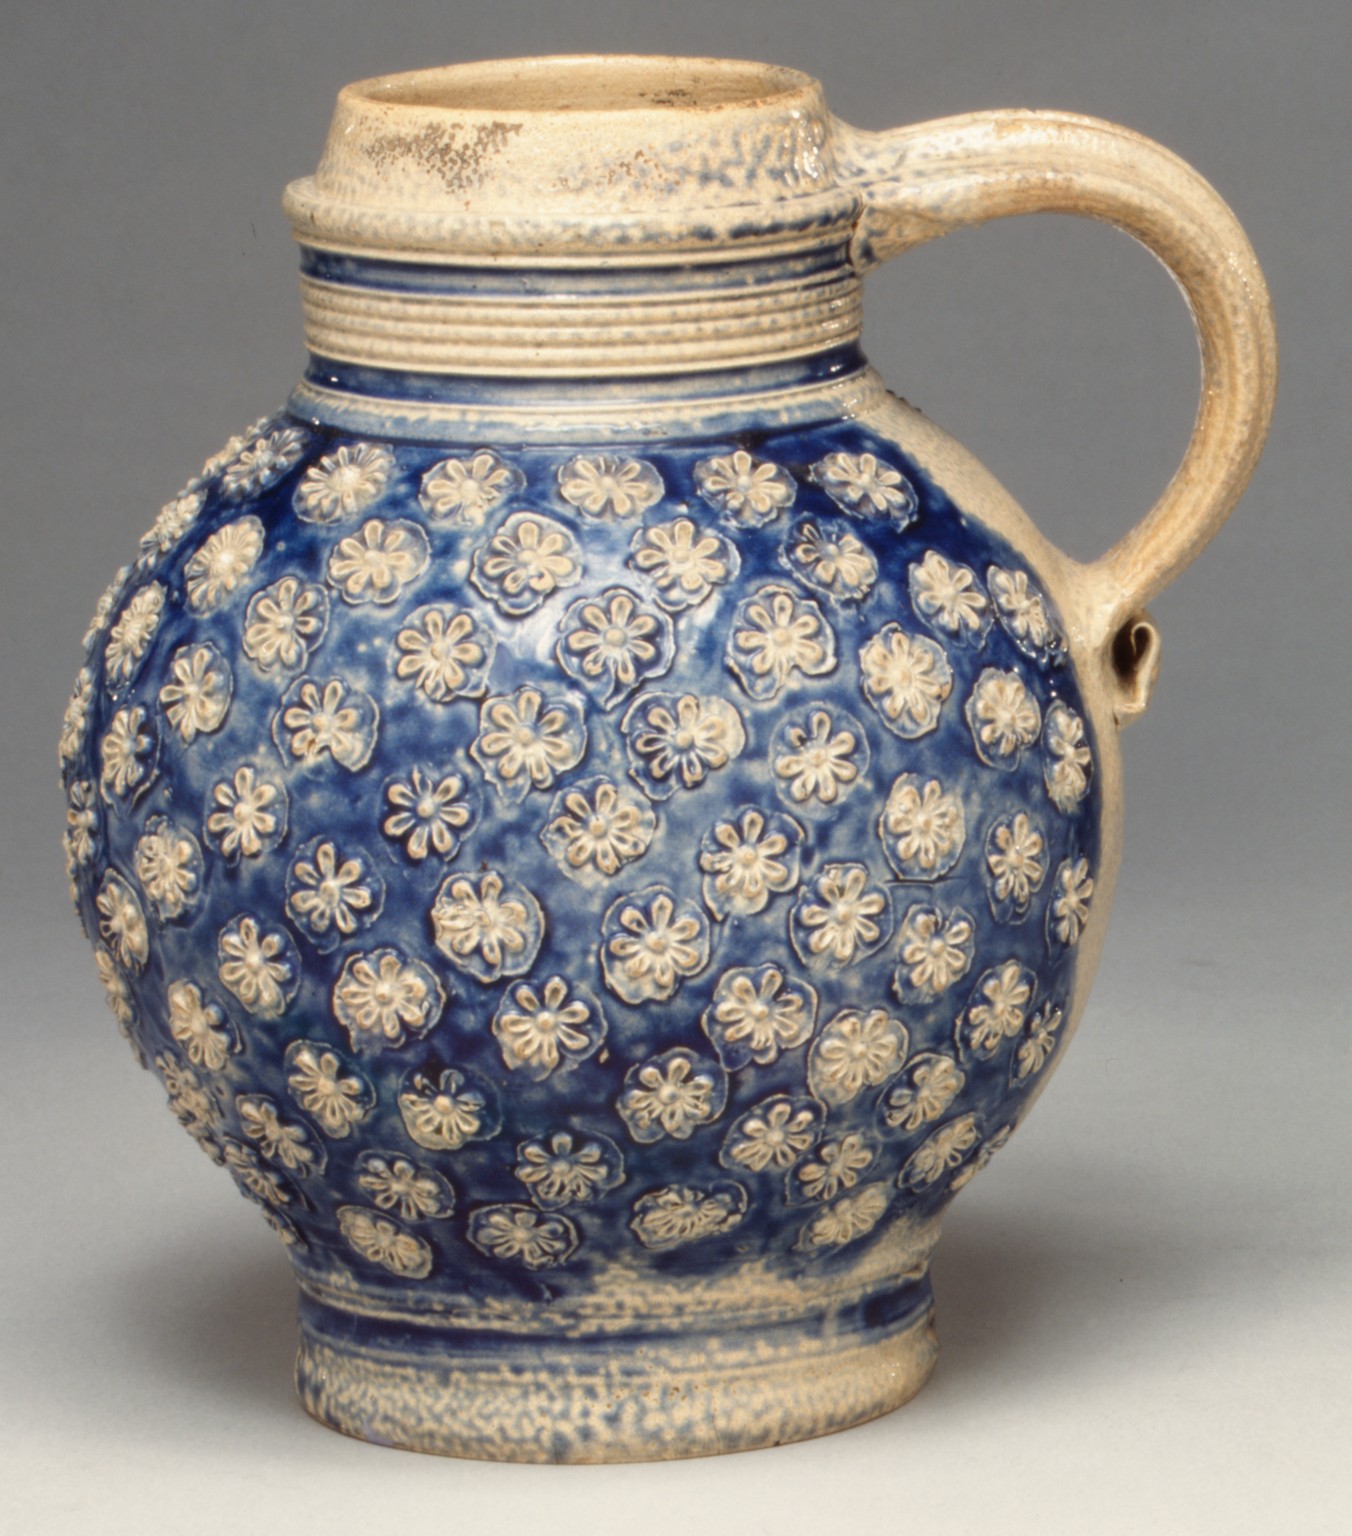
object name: jug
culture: german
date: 1680-1700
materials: stoneware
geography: germany